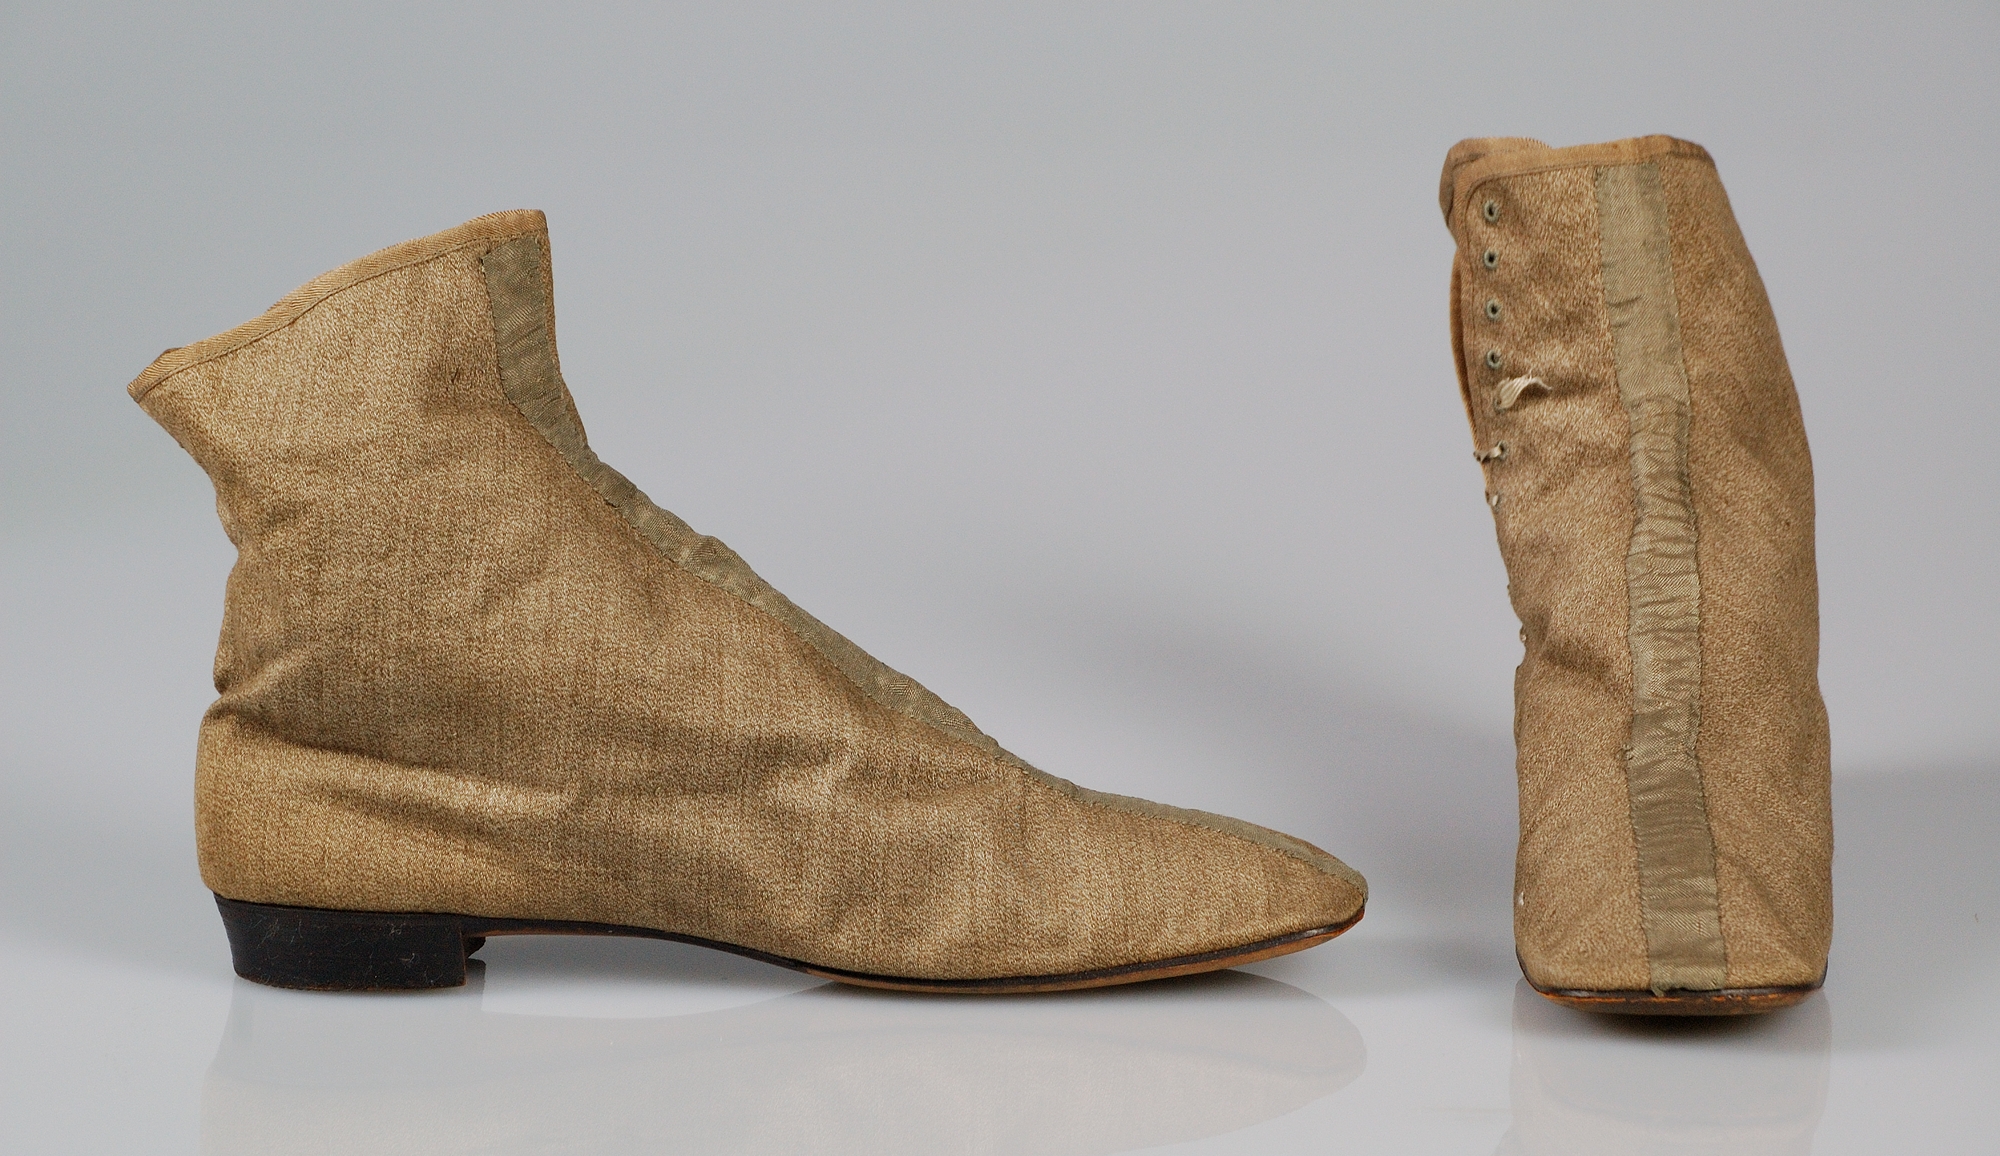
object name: walking boot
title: Walking boots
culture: american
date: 1860-1875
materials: wool